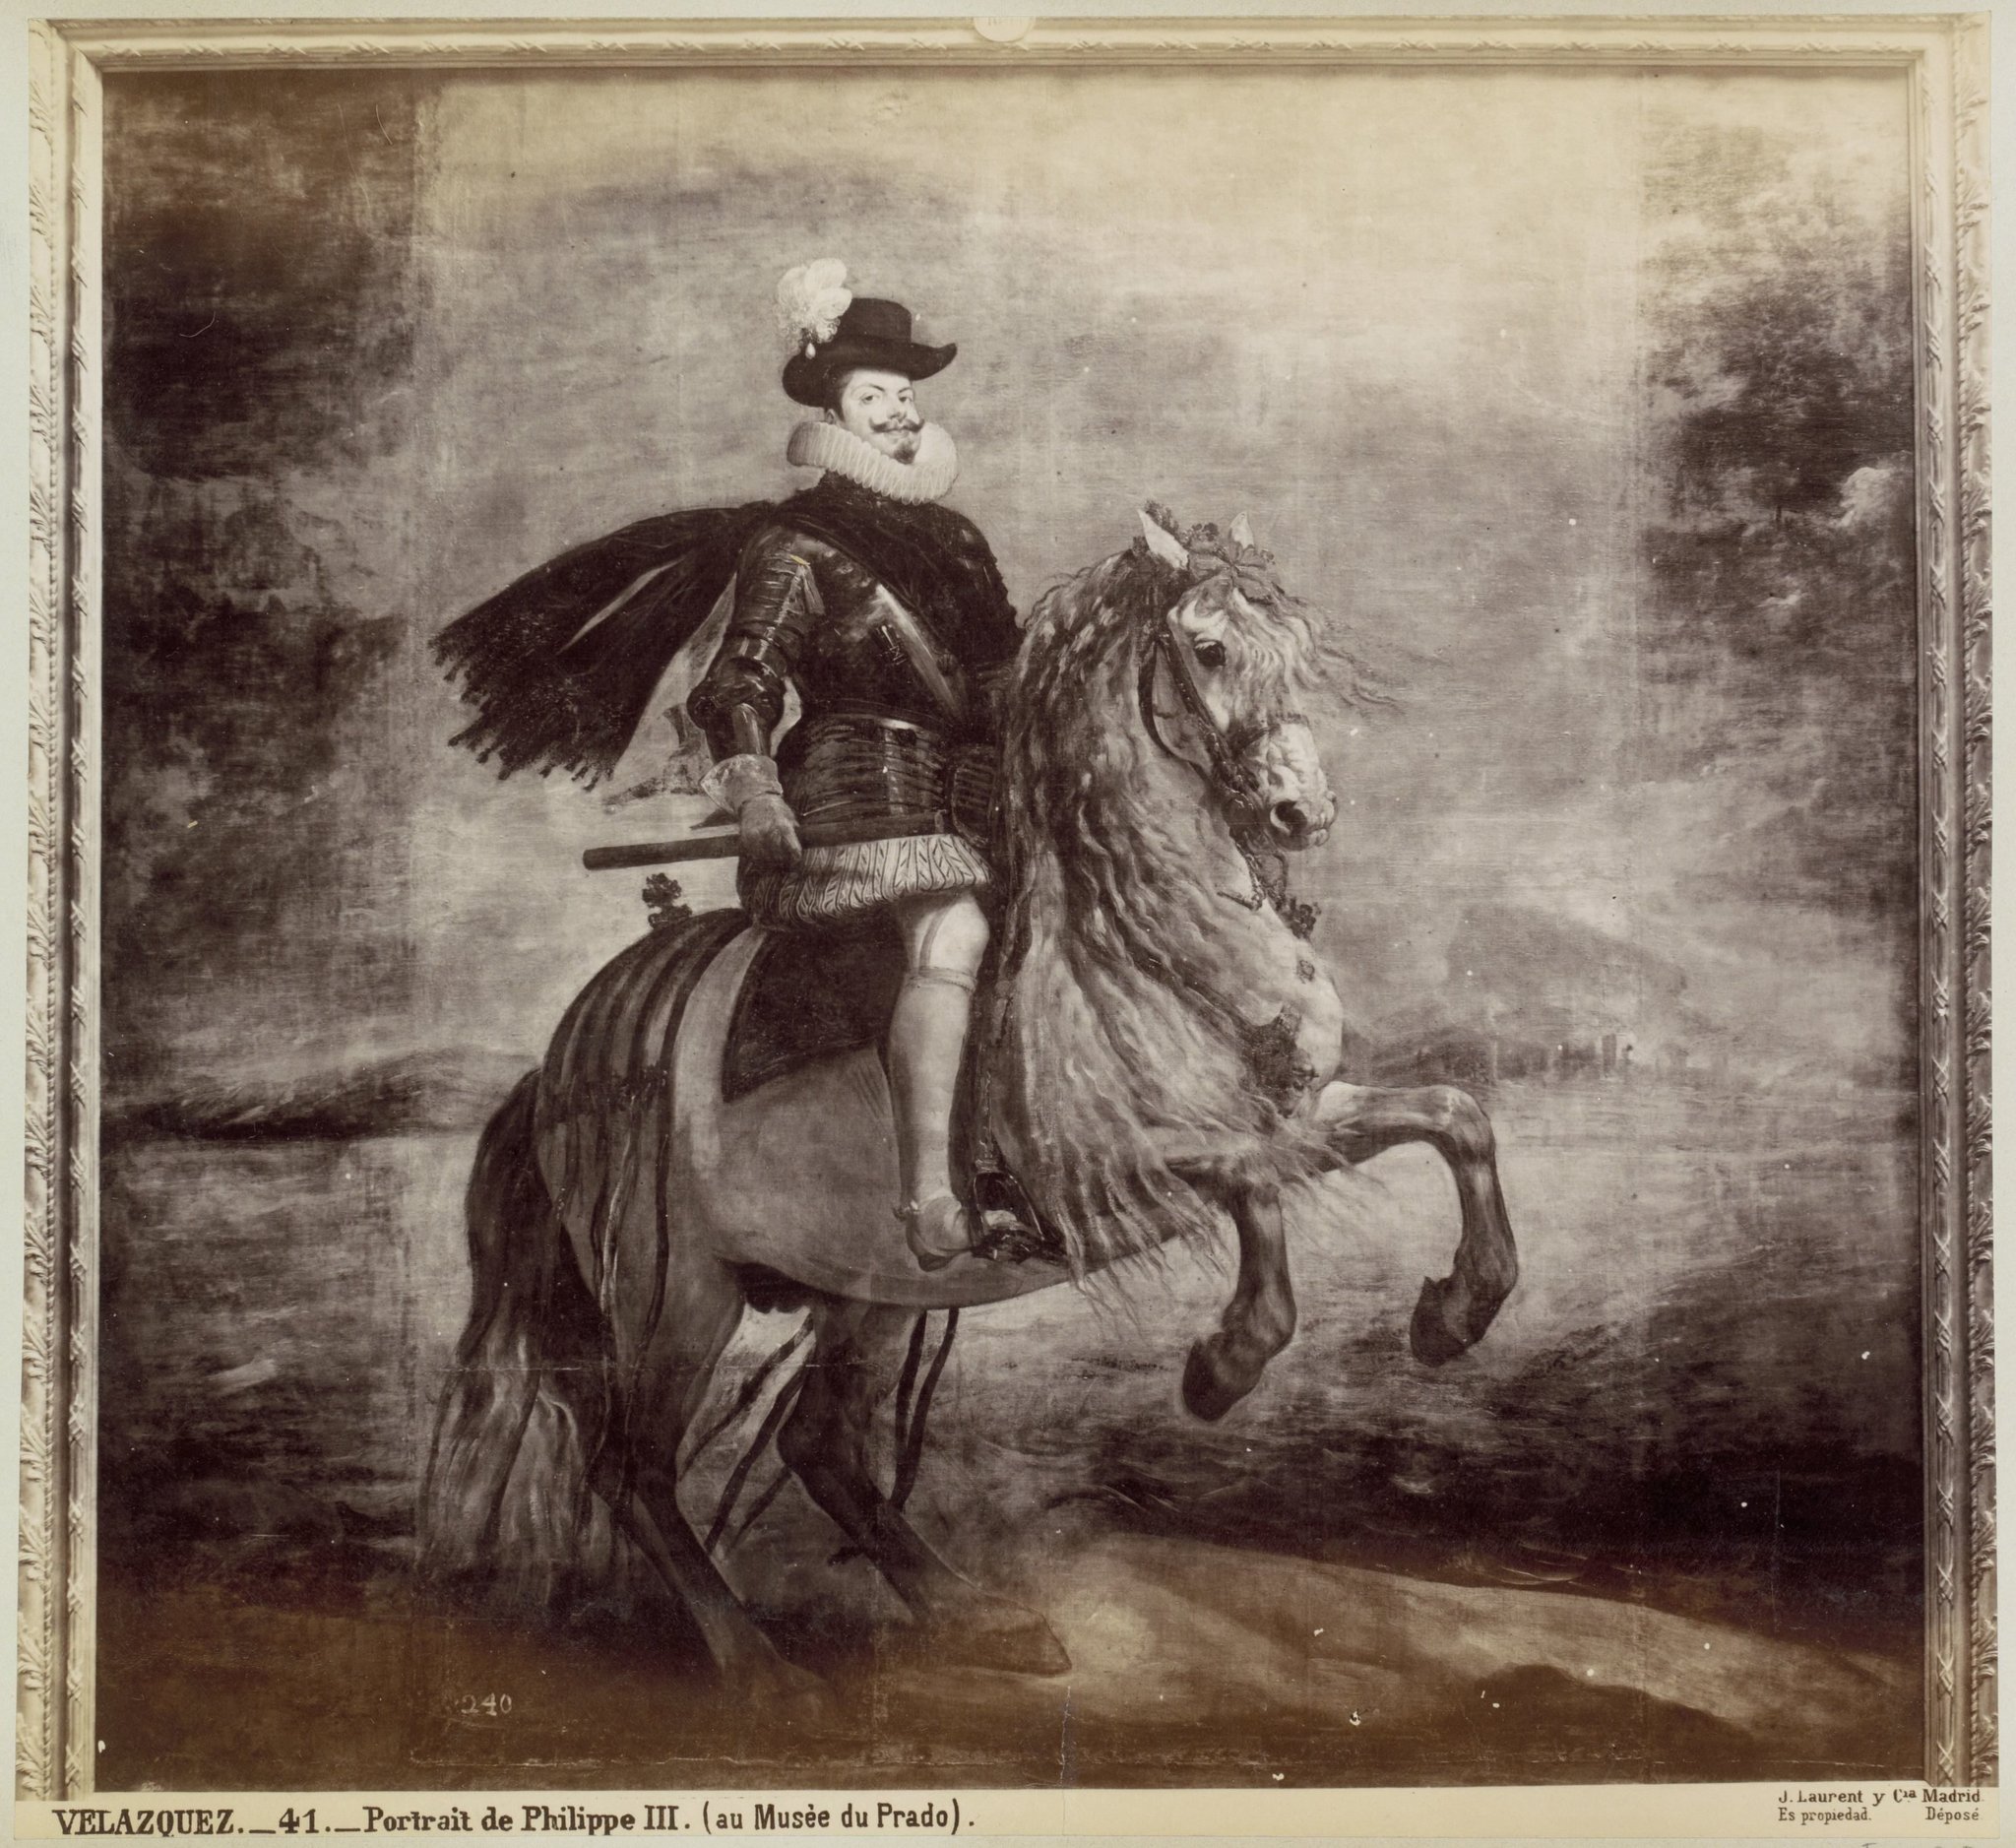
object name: reproduction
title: VELAZQUEZ.- Portrait de Phlippe III. (au Musée du Prado).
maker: juan laurent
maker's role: publisher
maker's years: 1816-1896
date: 1857-1880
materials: cardboard, paper, photographic support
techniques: albumen print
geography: madrid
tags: filips iii (koning van spanje), equestrian state-portrait, ruler, sovereign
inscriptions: negative number: ‘41’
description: Onderdeel van Reisalbum met foto's van bezienswaardigheden in Spanje en Marokko.